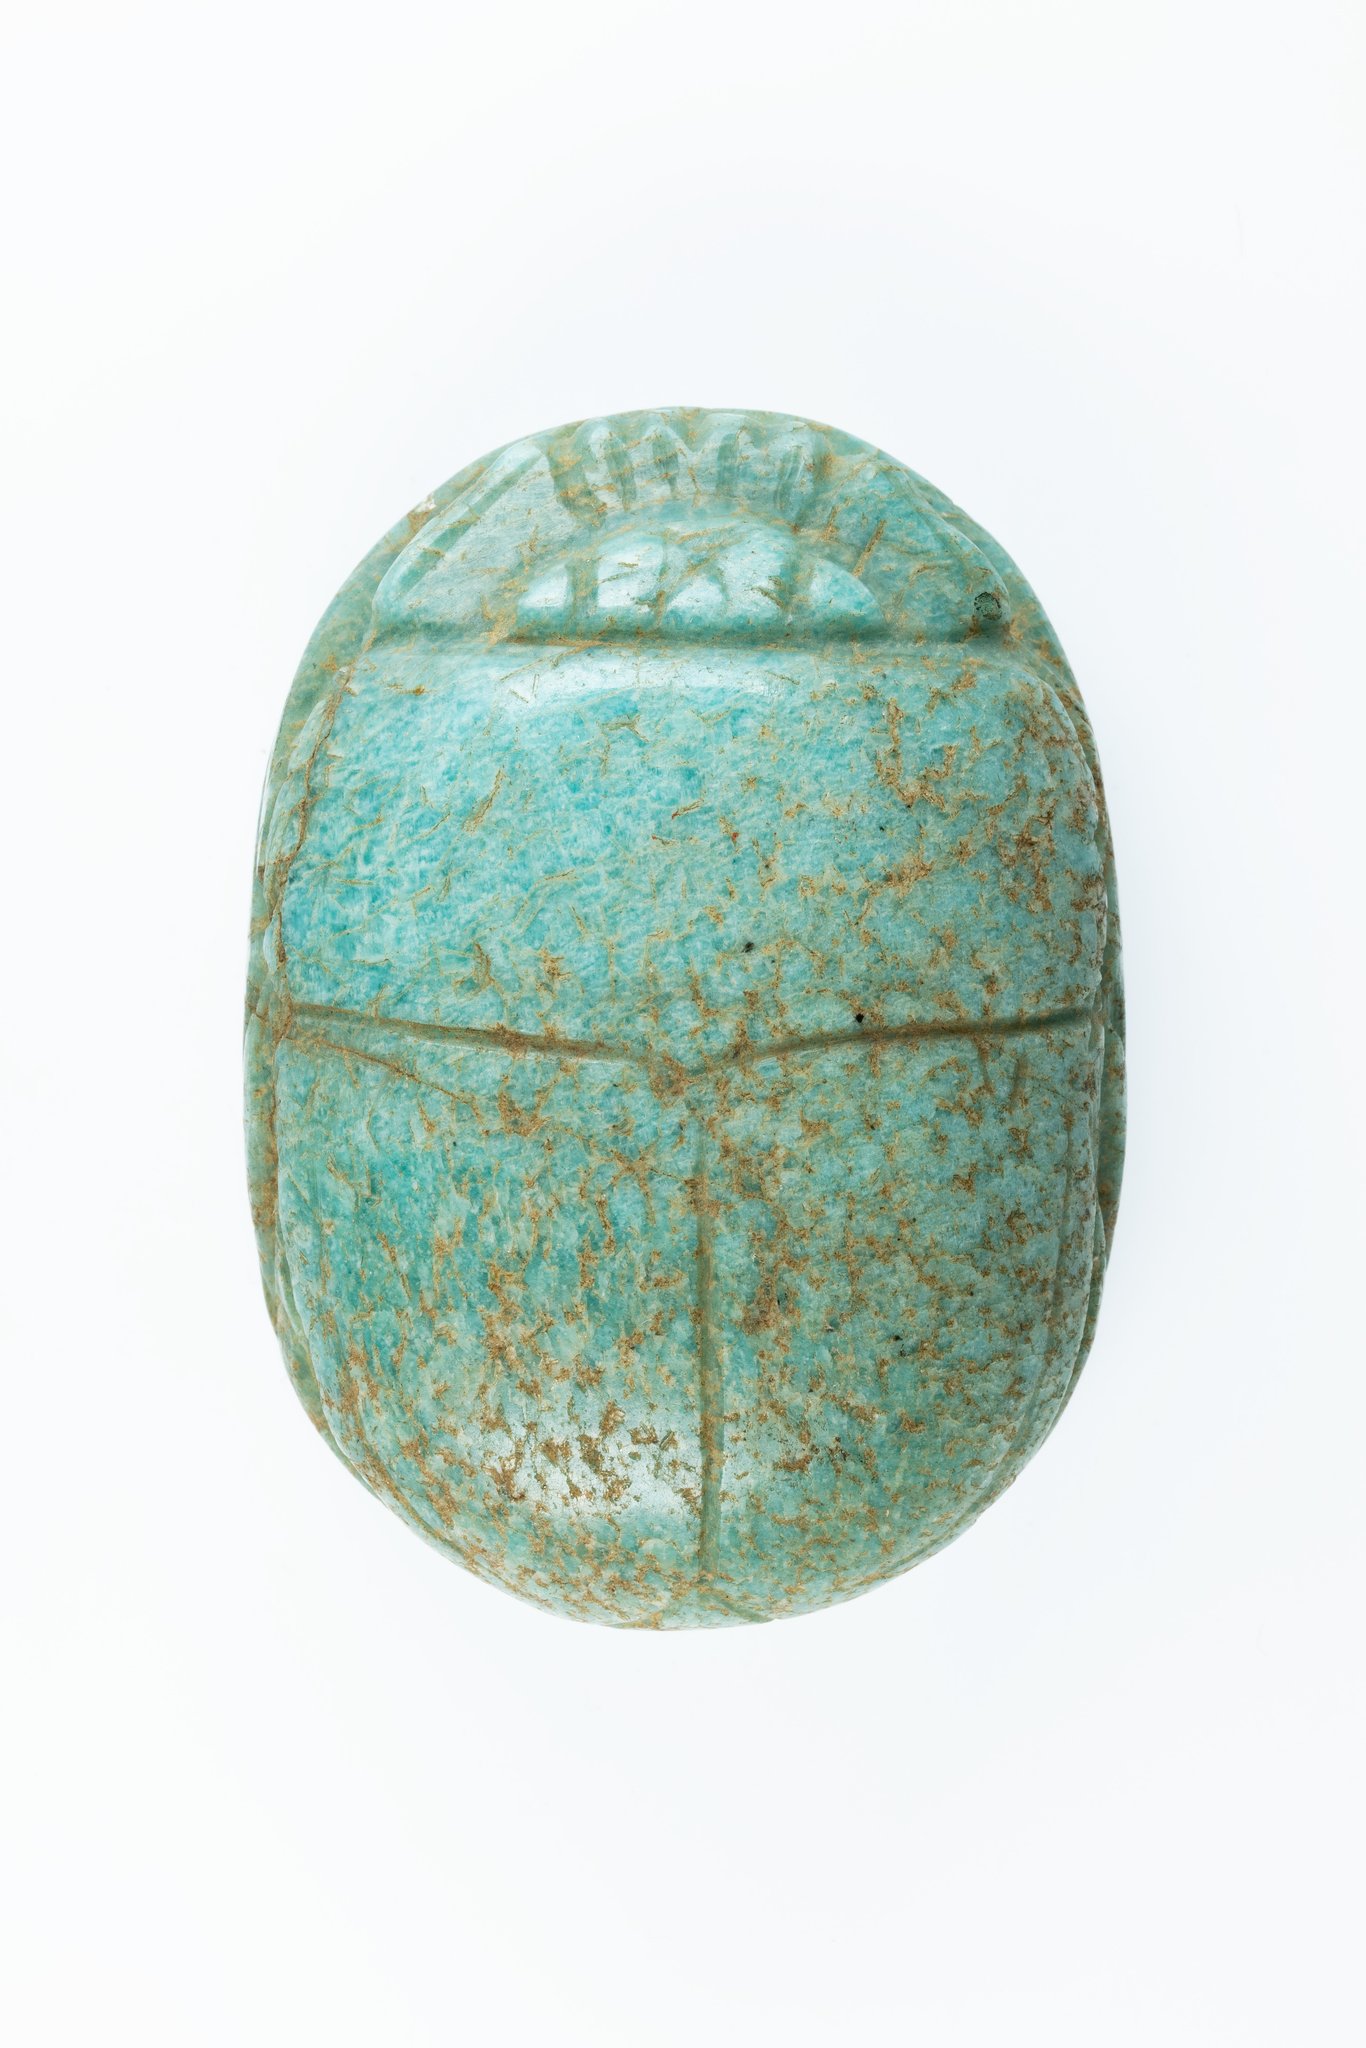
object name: heart scarab, uninscribed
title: Uninscribed Heart Scarab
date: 1070-664 BCE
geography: egypt